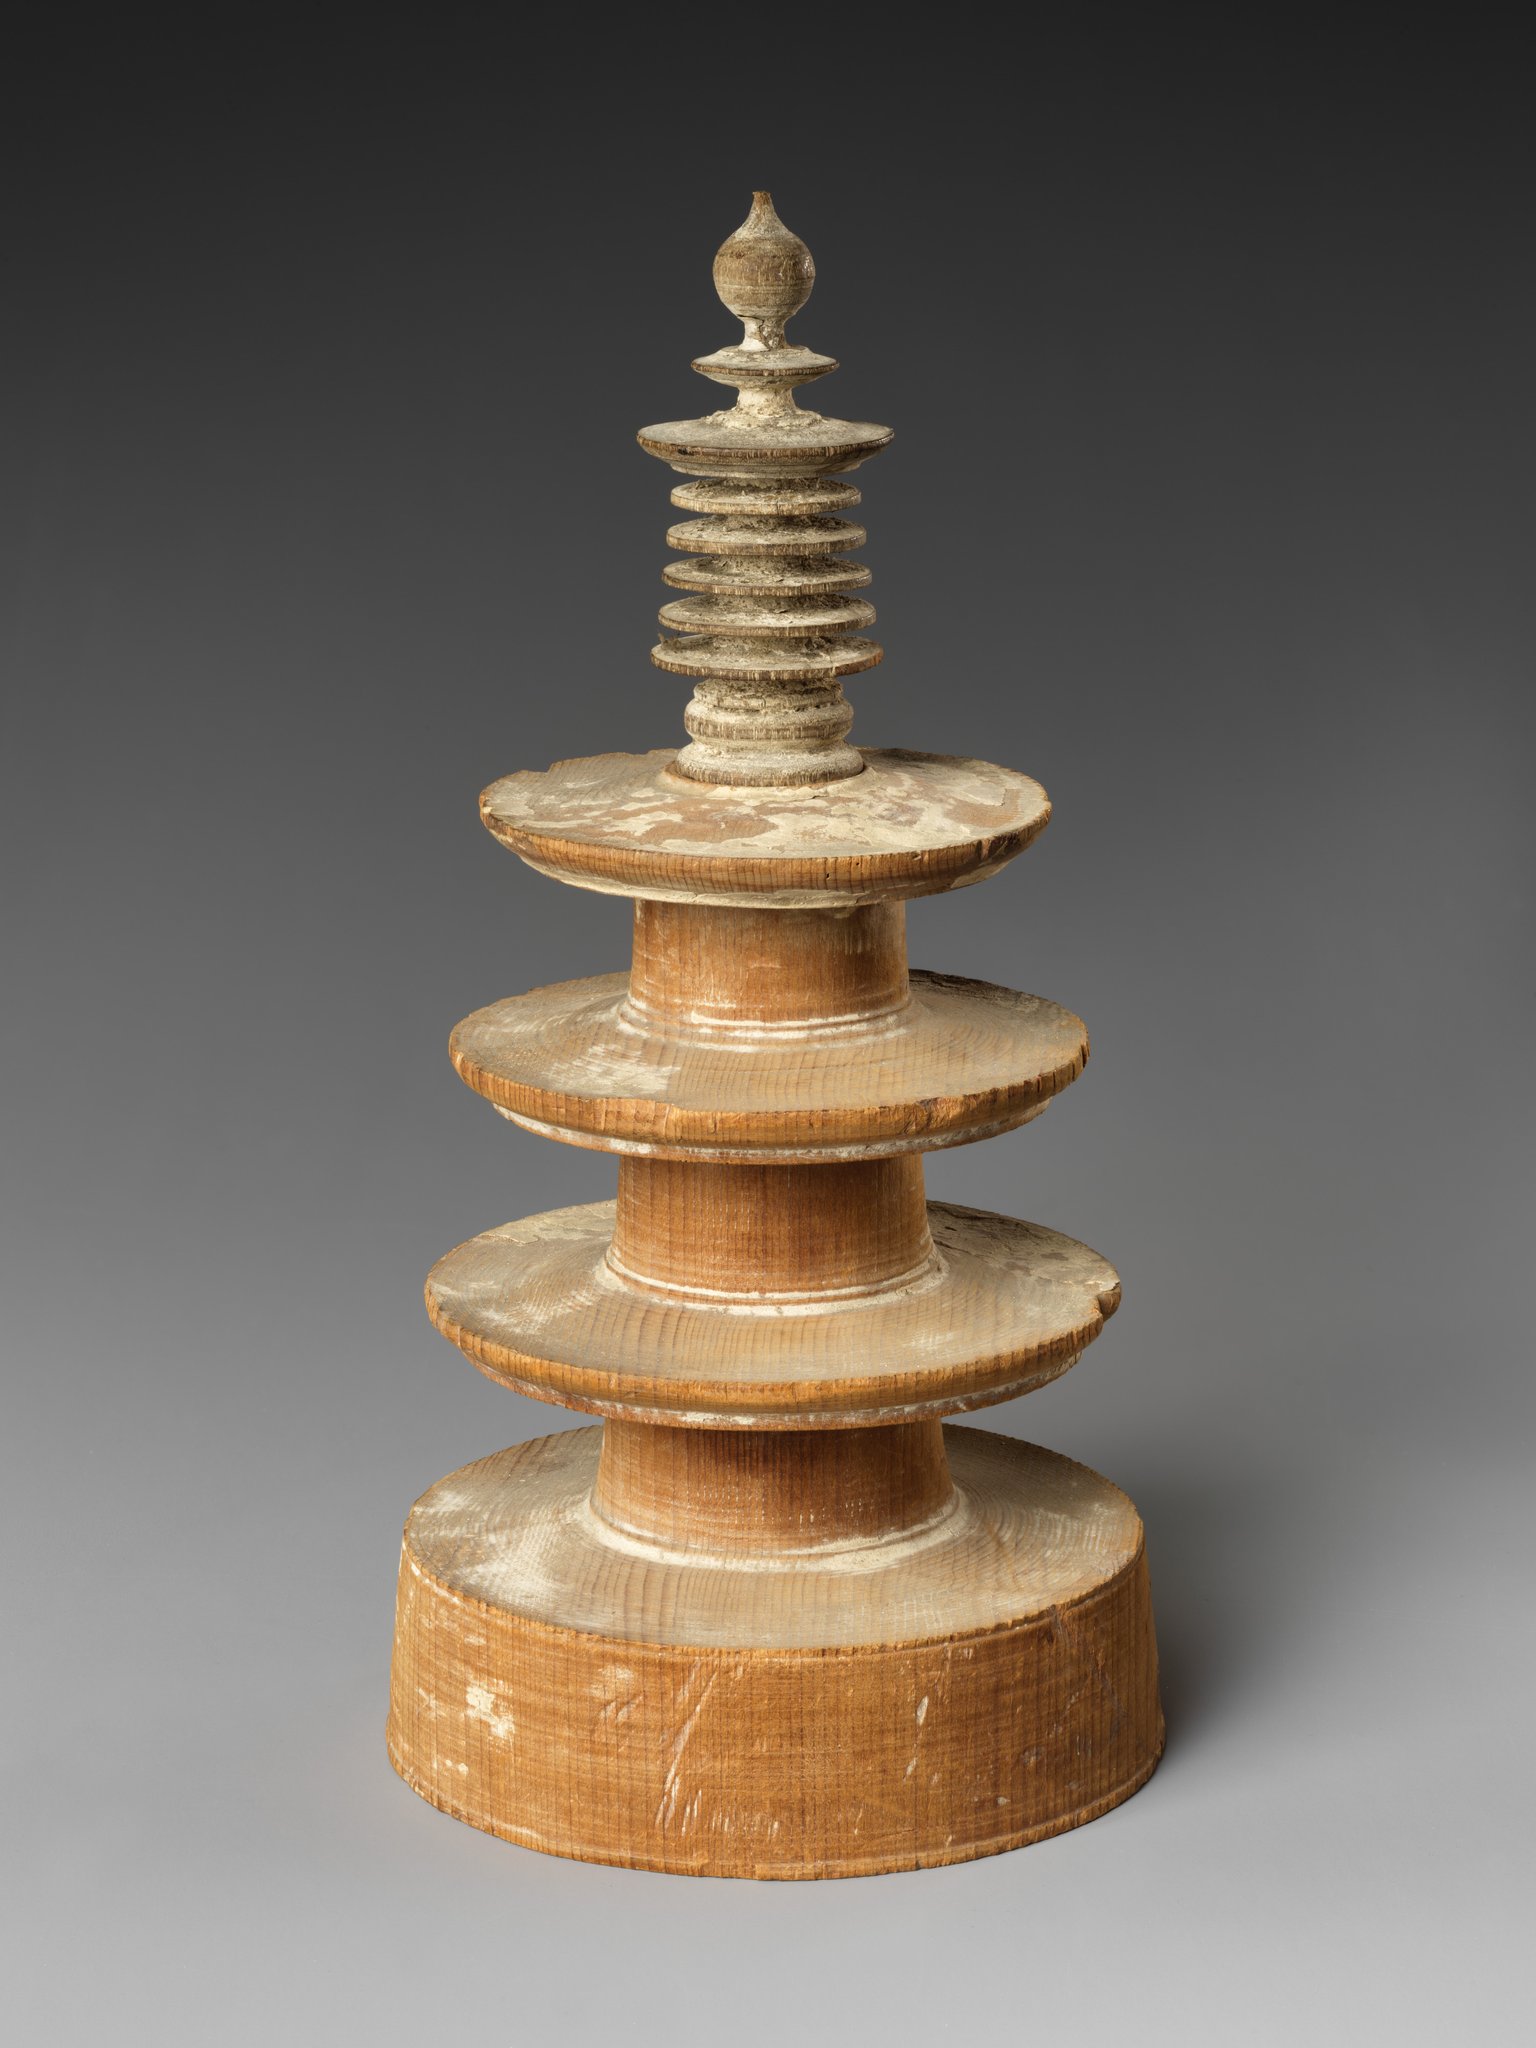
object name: stupa containing prayer roll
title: One of the “One Million Pagodas” (Hyakumanto) and Invocation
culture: japanese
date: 764-770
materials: wood, ink, paper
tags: pagodas